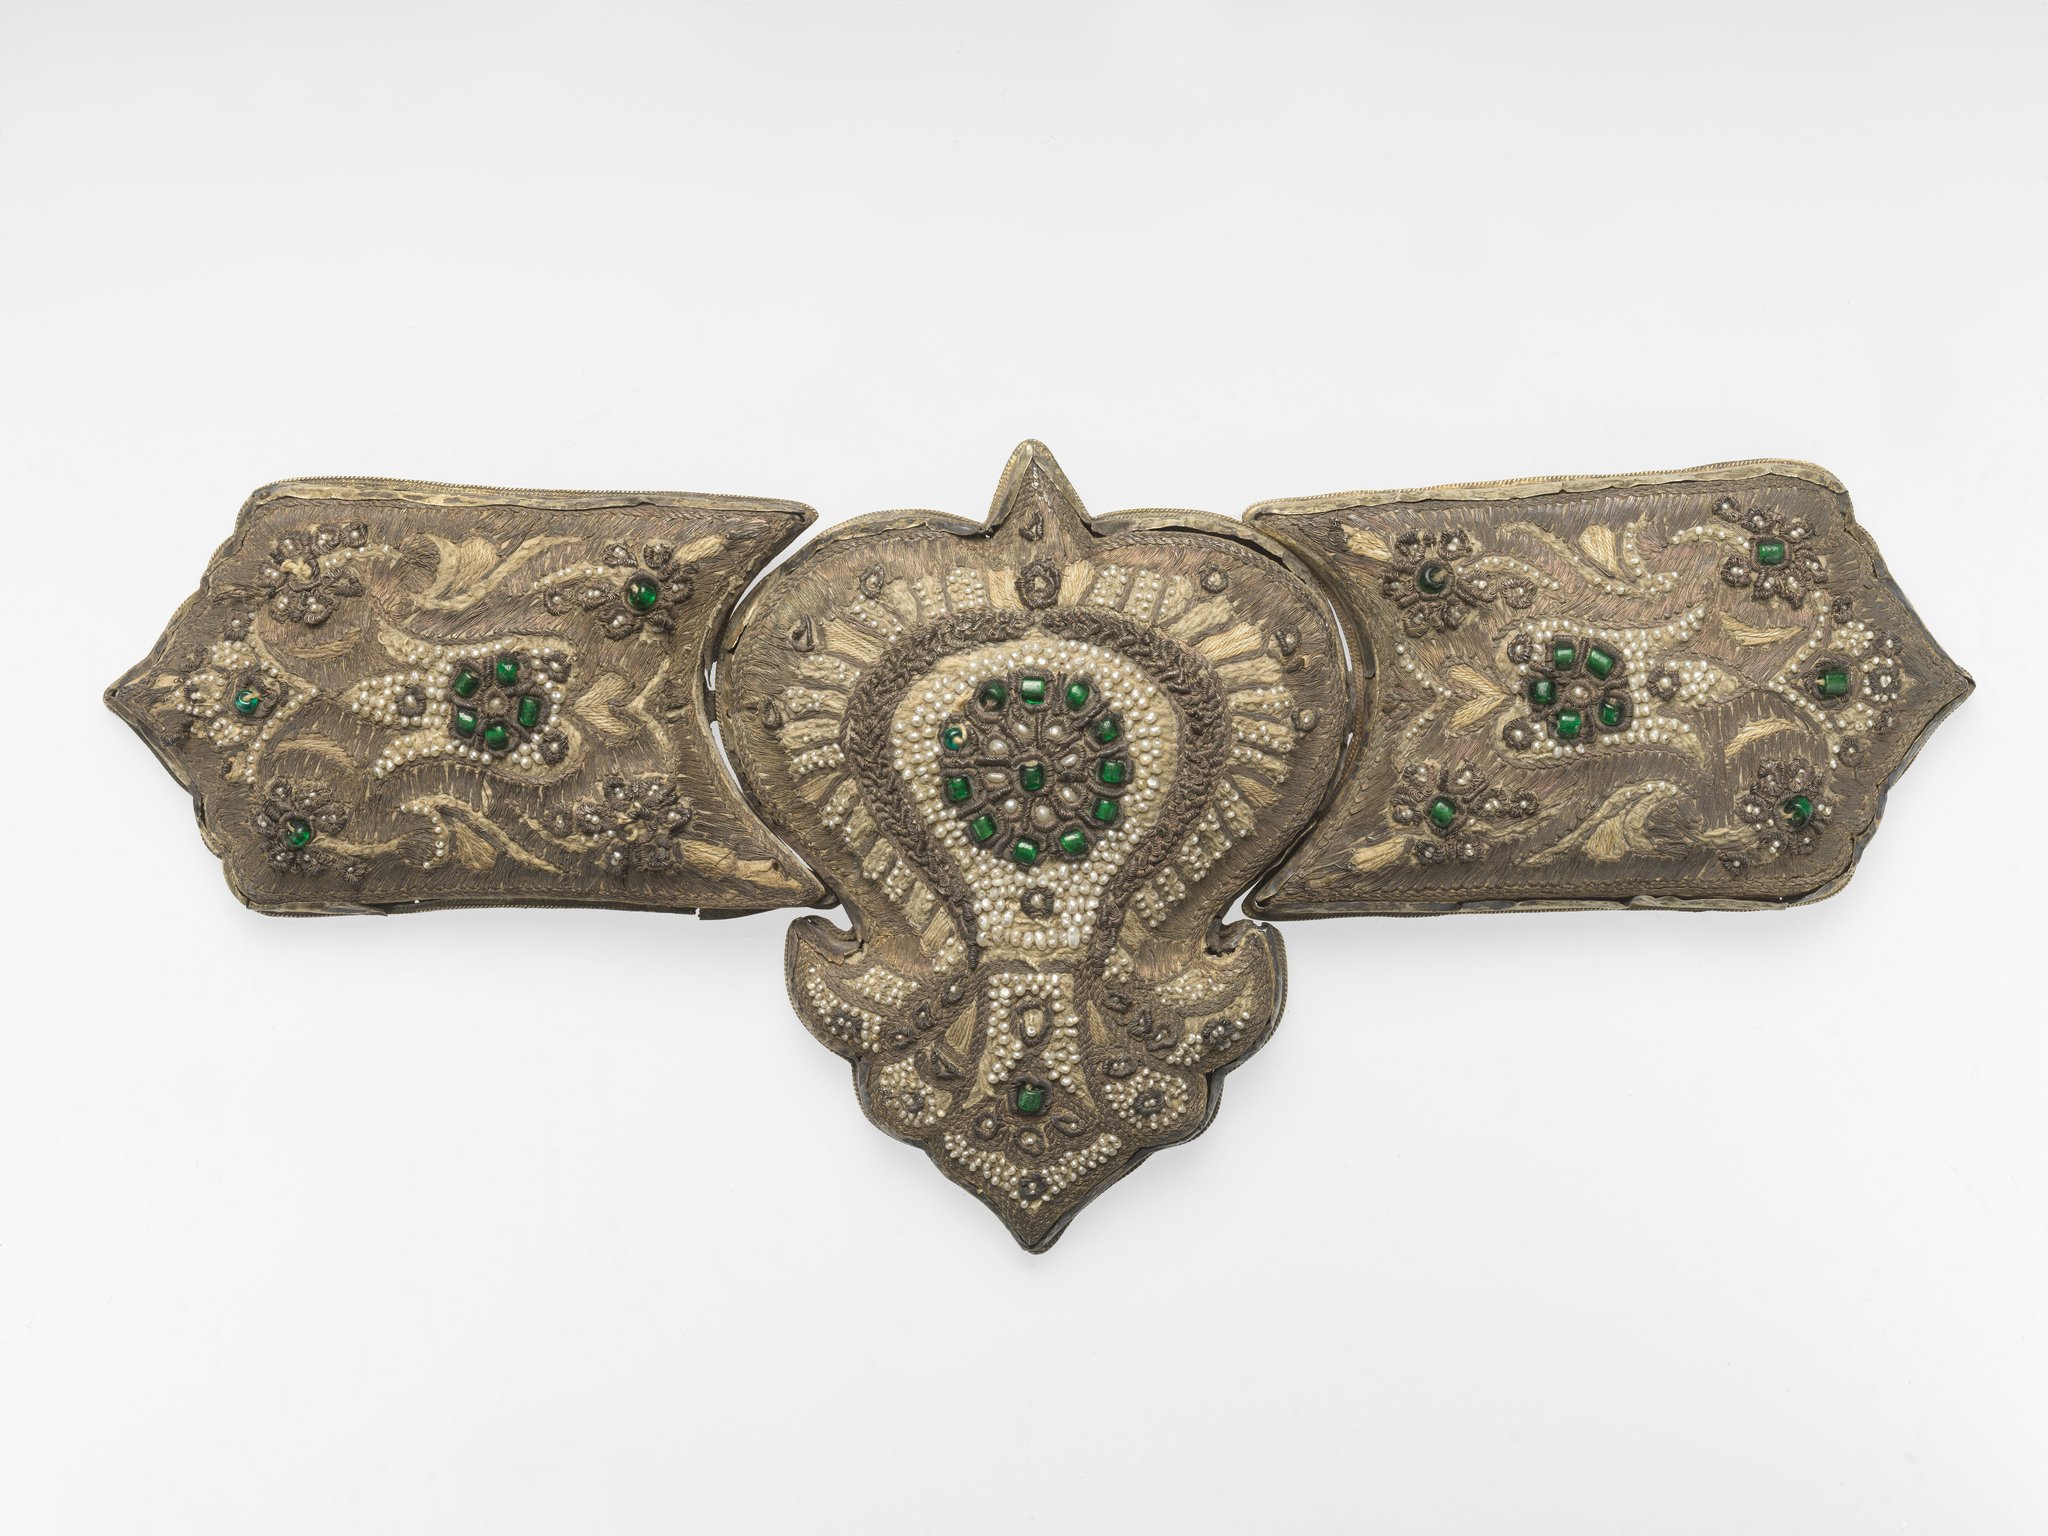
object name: girdle clasp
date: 1801-1900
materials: glass, gold thread, pearl, silver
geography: cyprus